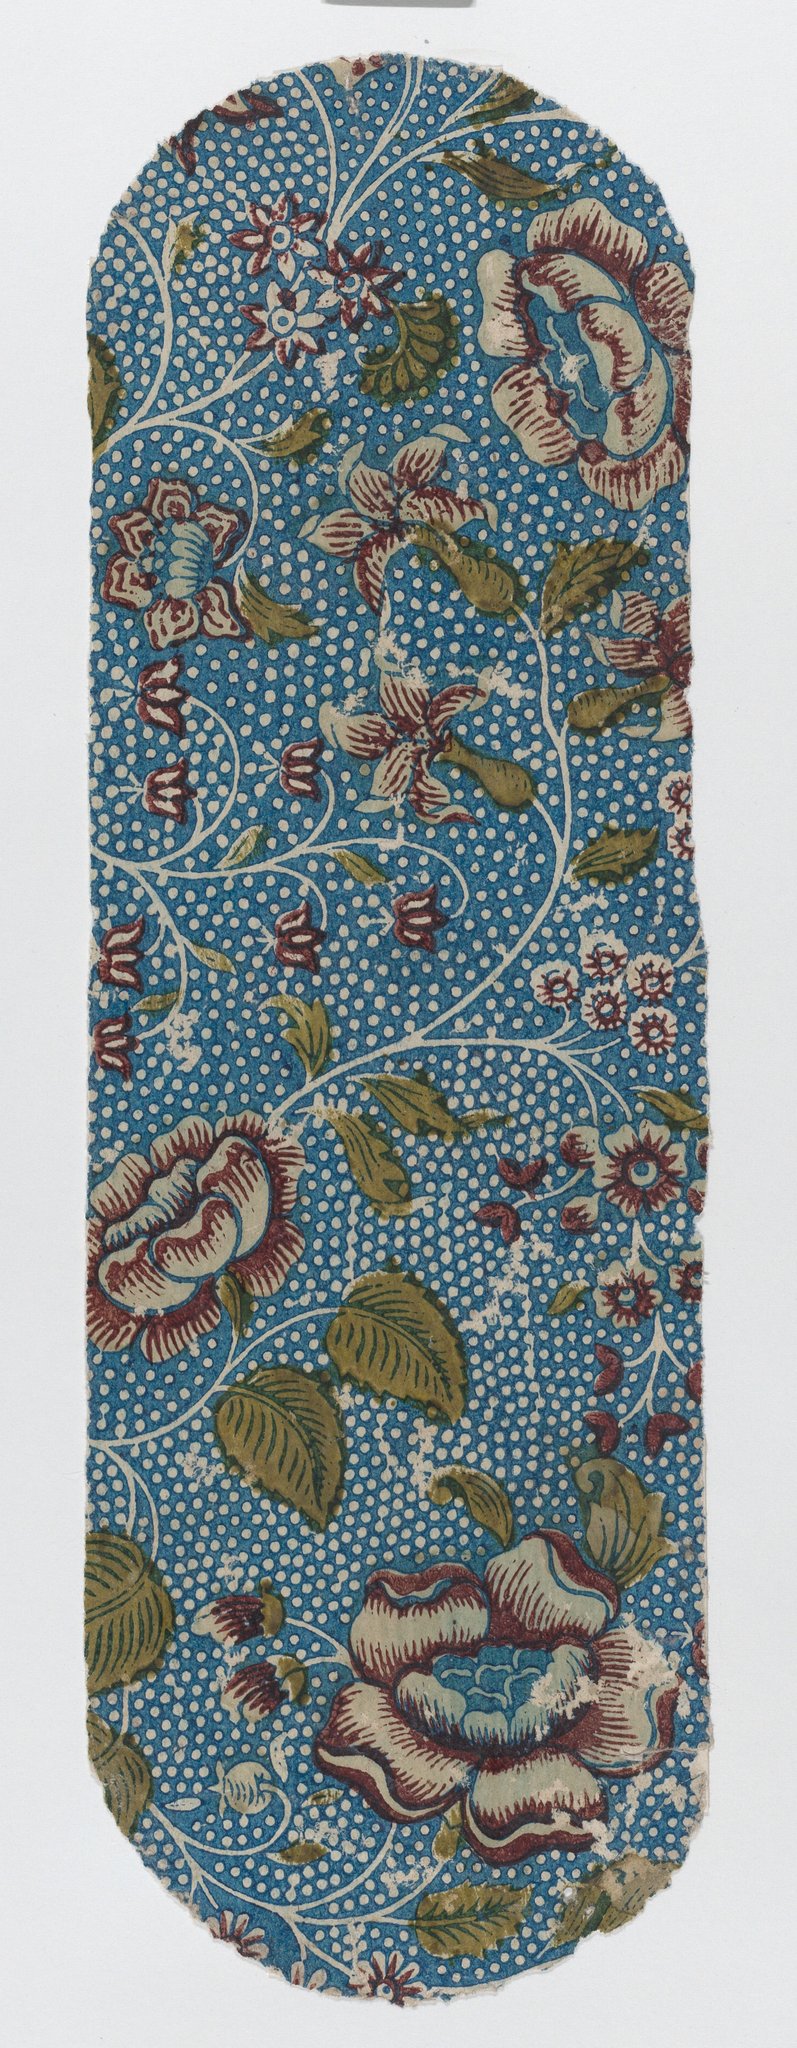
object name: print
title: Sheet with an overall floral and dot pattern on blue background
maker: Anonymous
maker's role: artist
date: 1846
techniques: relief print